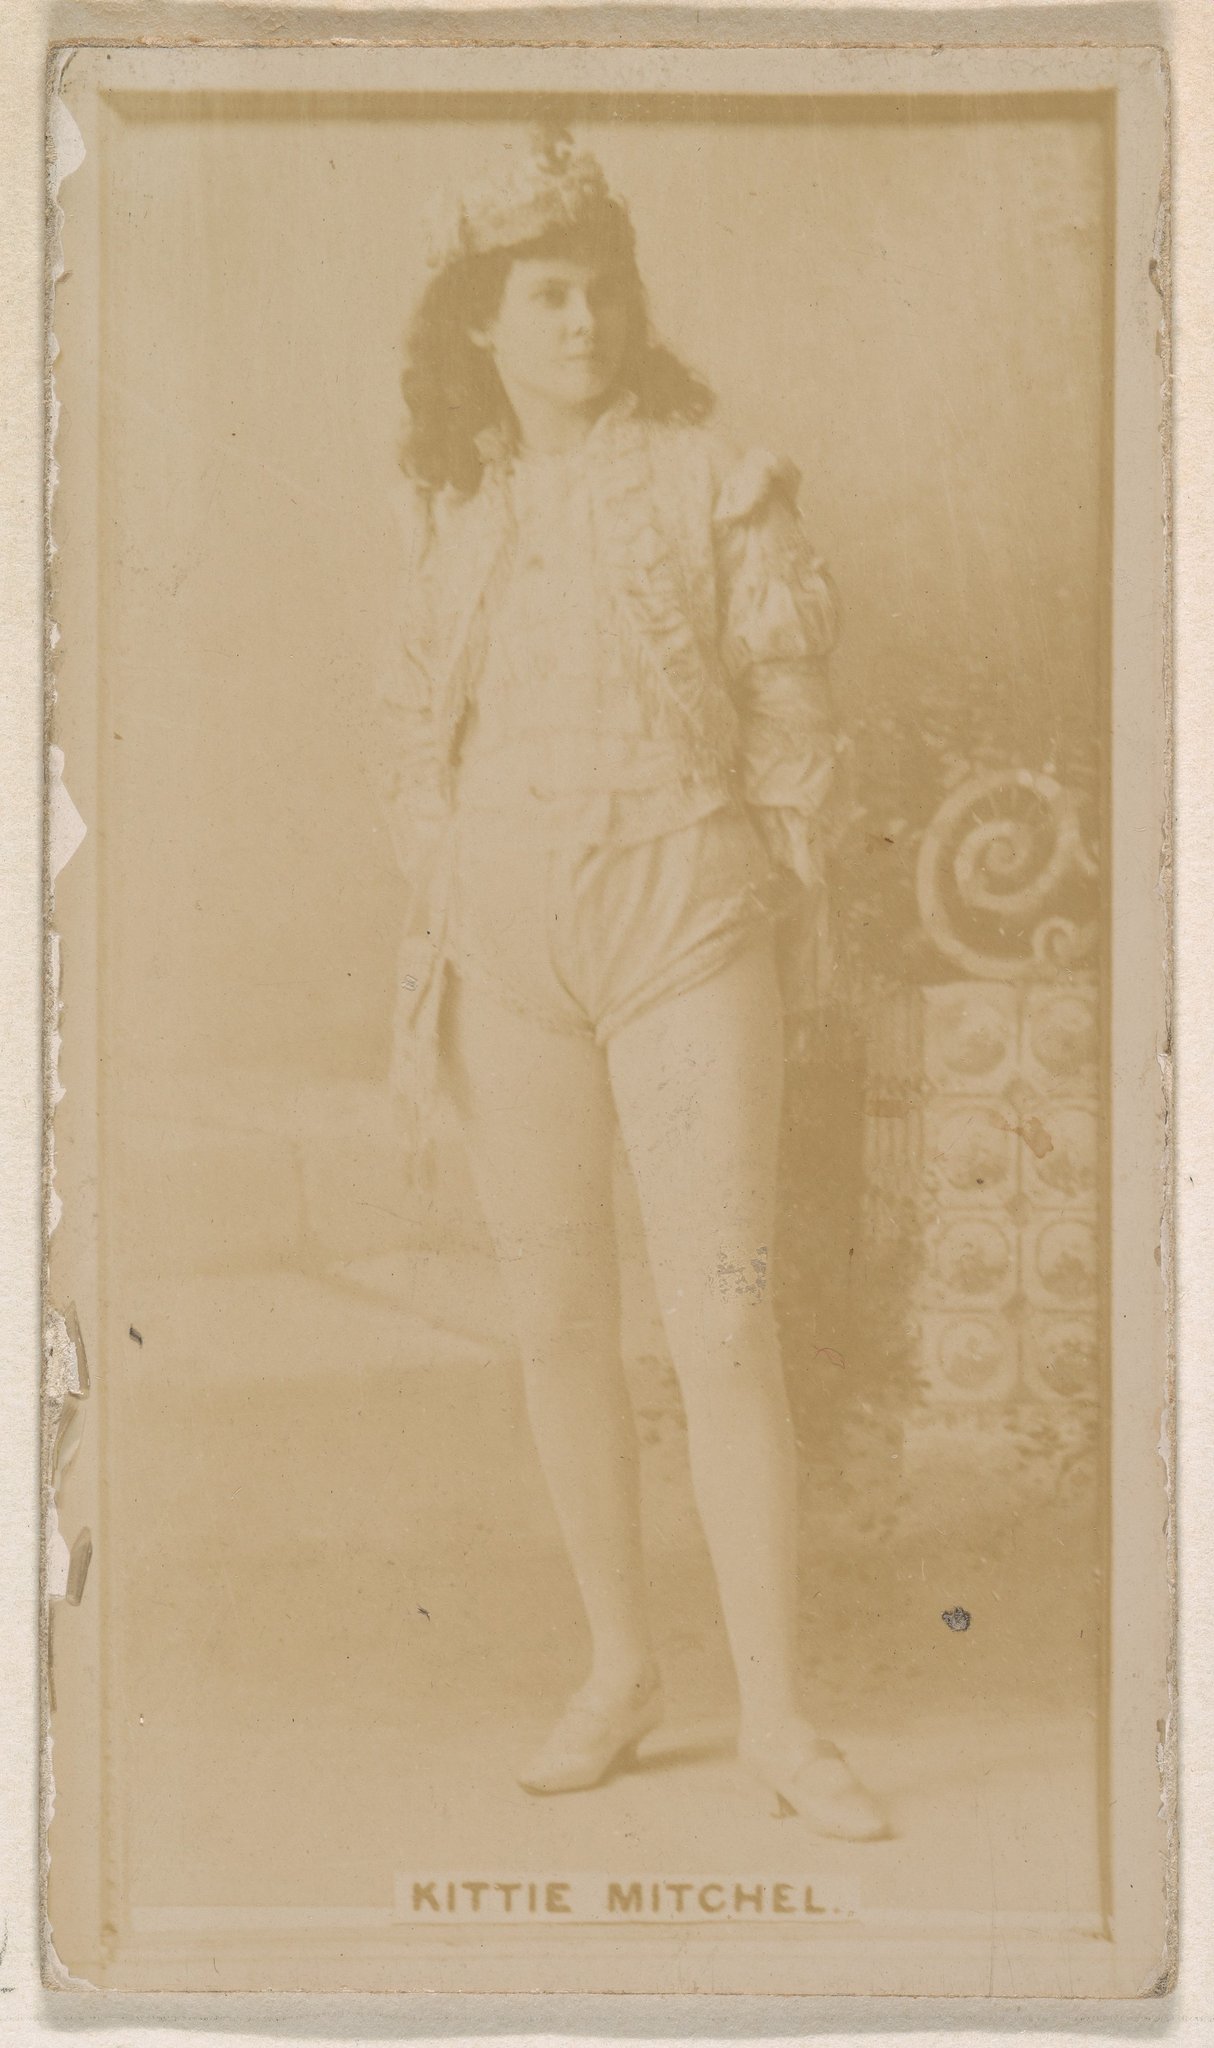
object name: photograph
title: Kittie Mitchell, from the Actresses series (N245) issued by Kinney Brothers to promote Sweet Caporal Cigarettes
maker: kinney brothers tobacco company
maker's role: publisher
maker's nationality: american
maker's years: 1869-2011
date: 1890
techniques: albumen silver print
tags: portraits,women,actresses